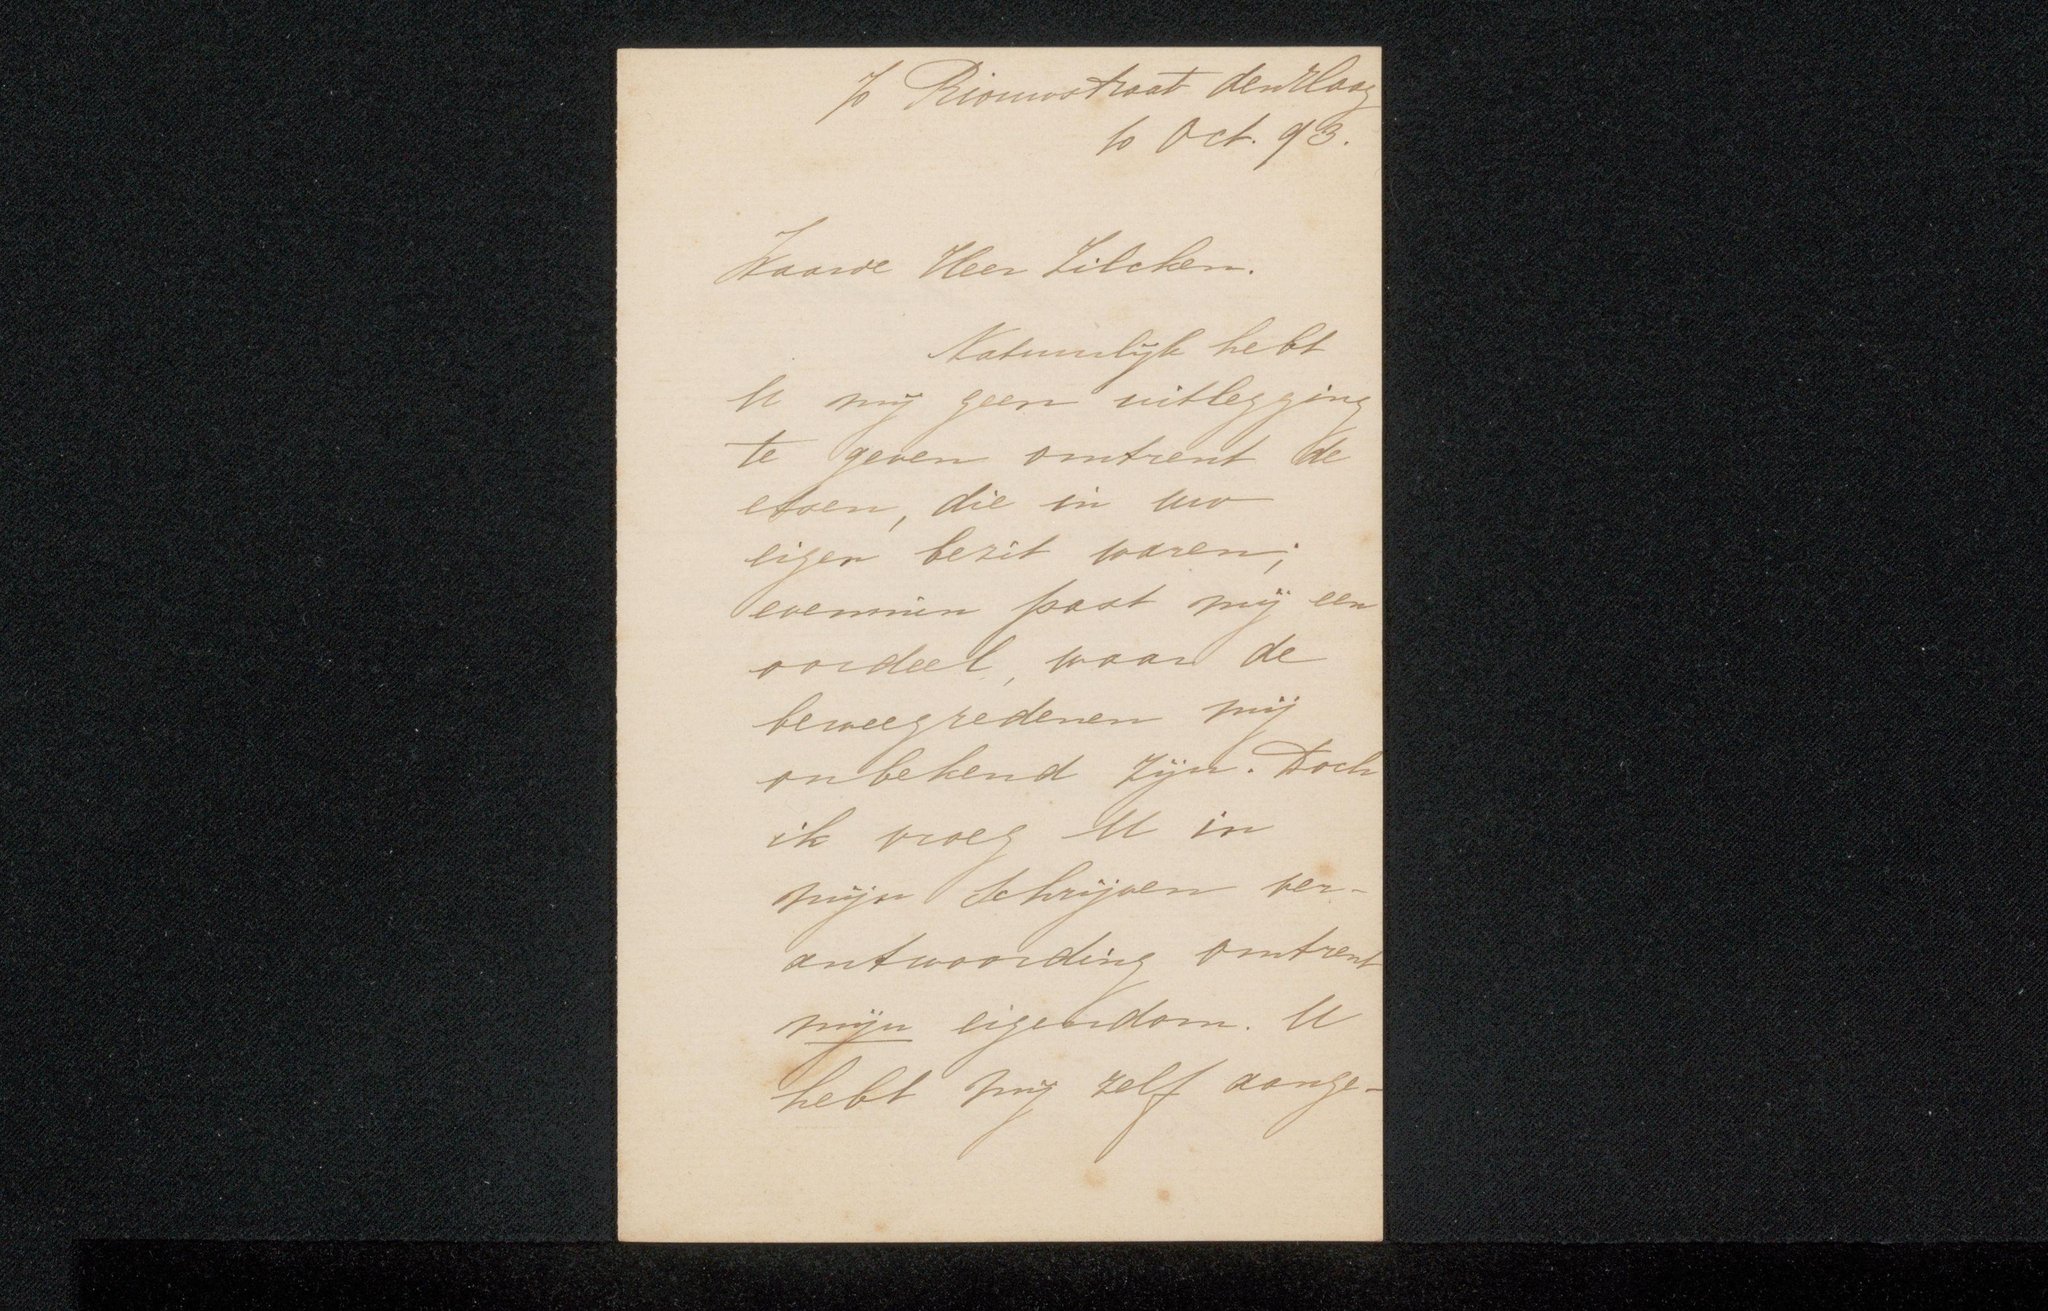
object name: letter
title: Brief aan Philip Zilcken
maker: ariette sophia jeannette mauve-carbentus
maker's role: draughtsman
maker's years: 1856-1894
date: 1893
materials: ink, paper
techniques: pen, writing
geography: the hague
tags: arnhem, print maker, anton mauve, martinus mouton, philip zilcken, the graphic arts, money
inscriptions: collector's mark: ‘RPK’